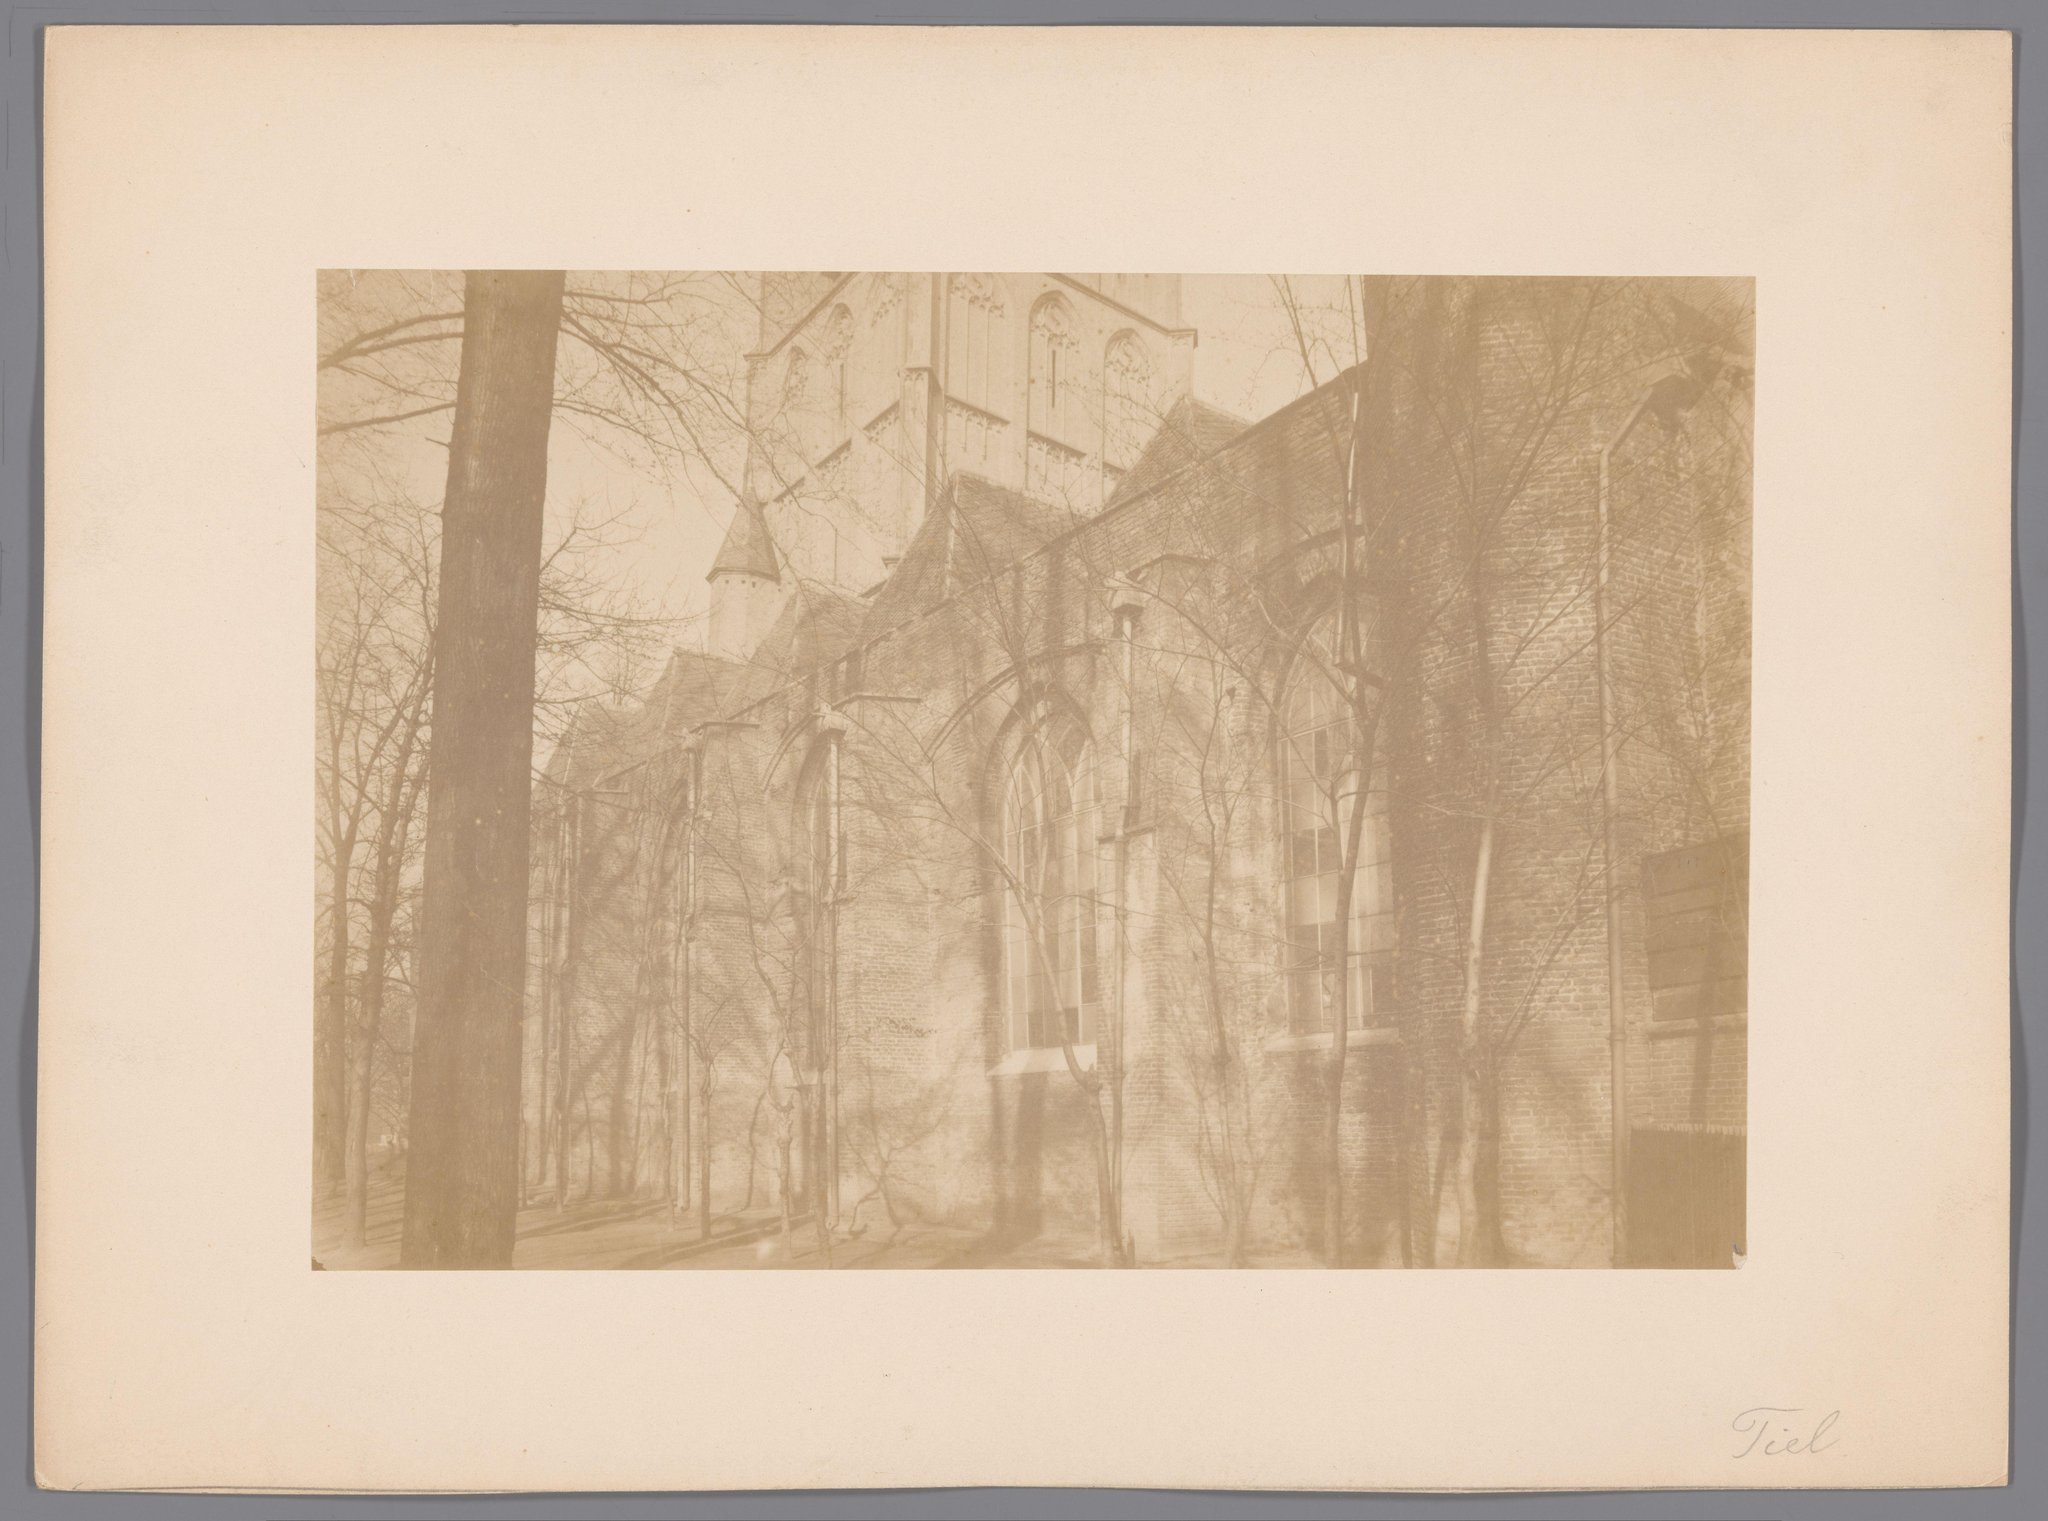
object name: photograph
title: Zuidzijde van de Grote of Sint-Maartenskerk te Tiel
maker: anoniem (monumentenzorg)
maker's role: fotograaf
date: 1893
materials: cardboard, photographic support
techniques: albumen print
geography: tiel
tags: church (exterior)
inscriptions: annotation: ‘Tiel’, annotation: ‘Tiel (G.)/ Zuidzijde v/d groote of st. Maartenskerk/ Maart 1893’